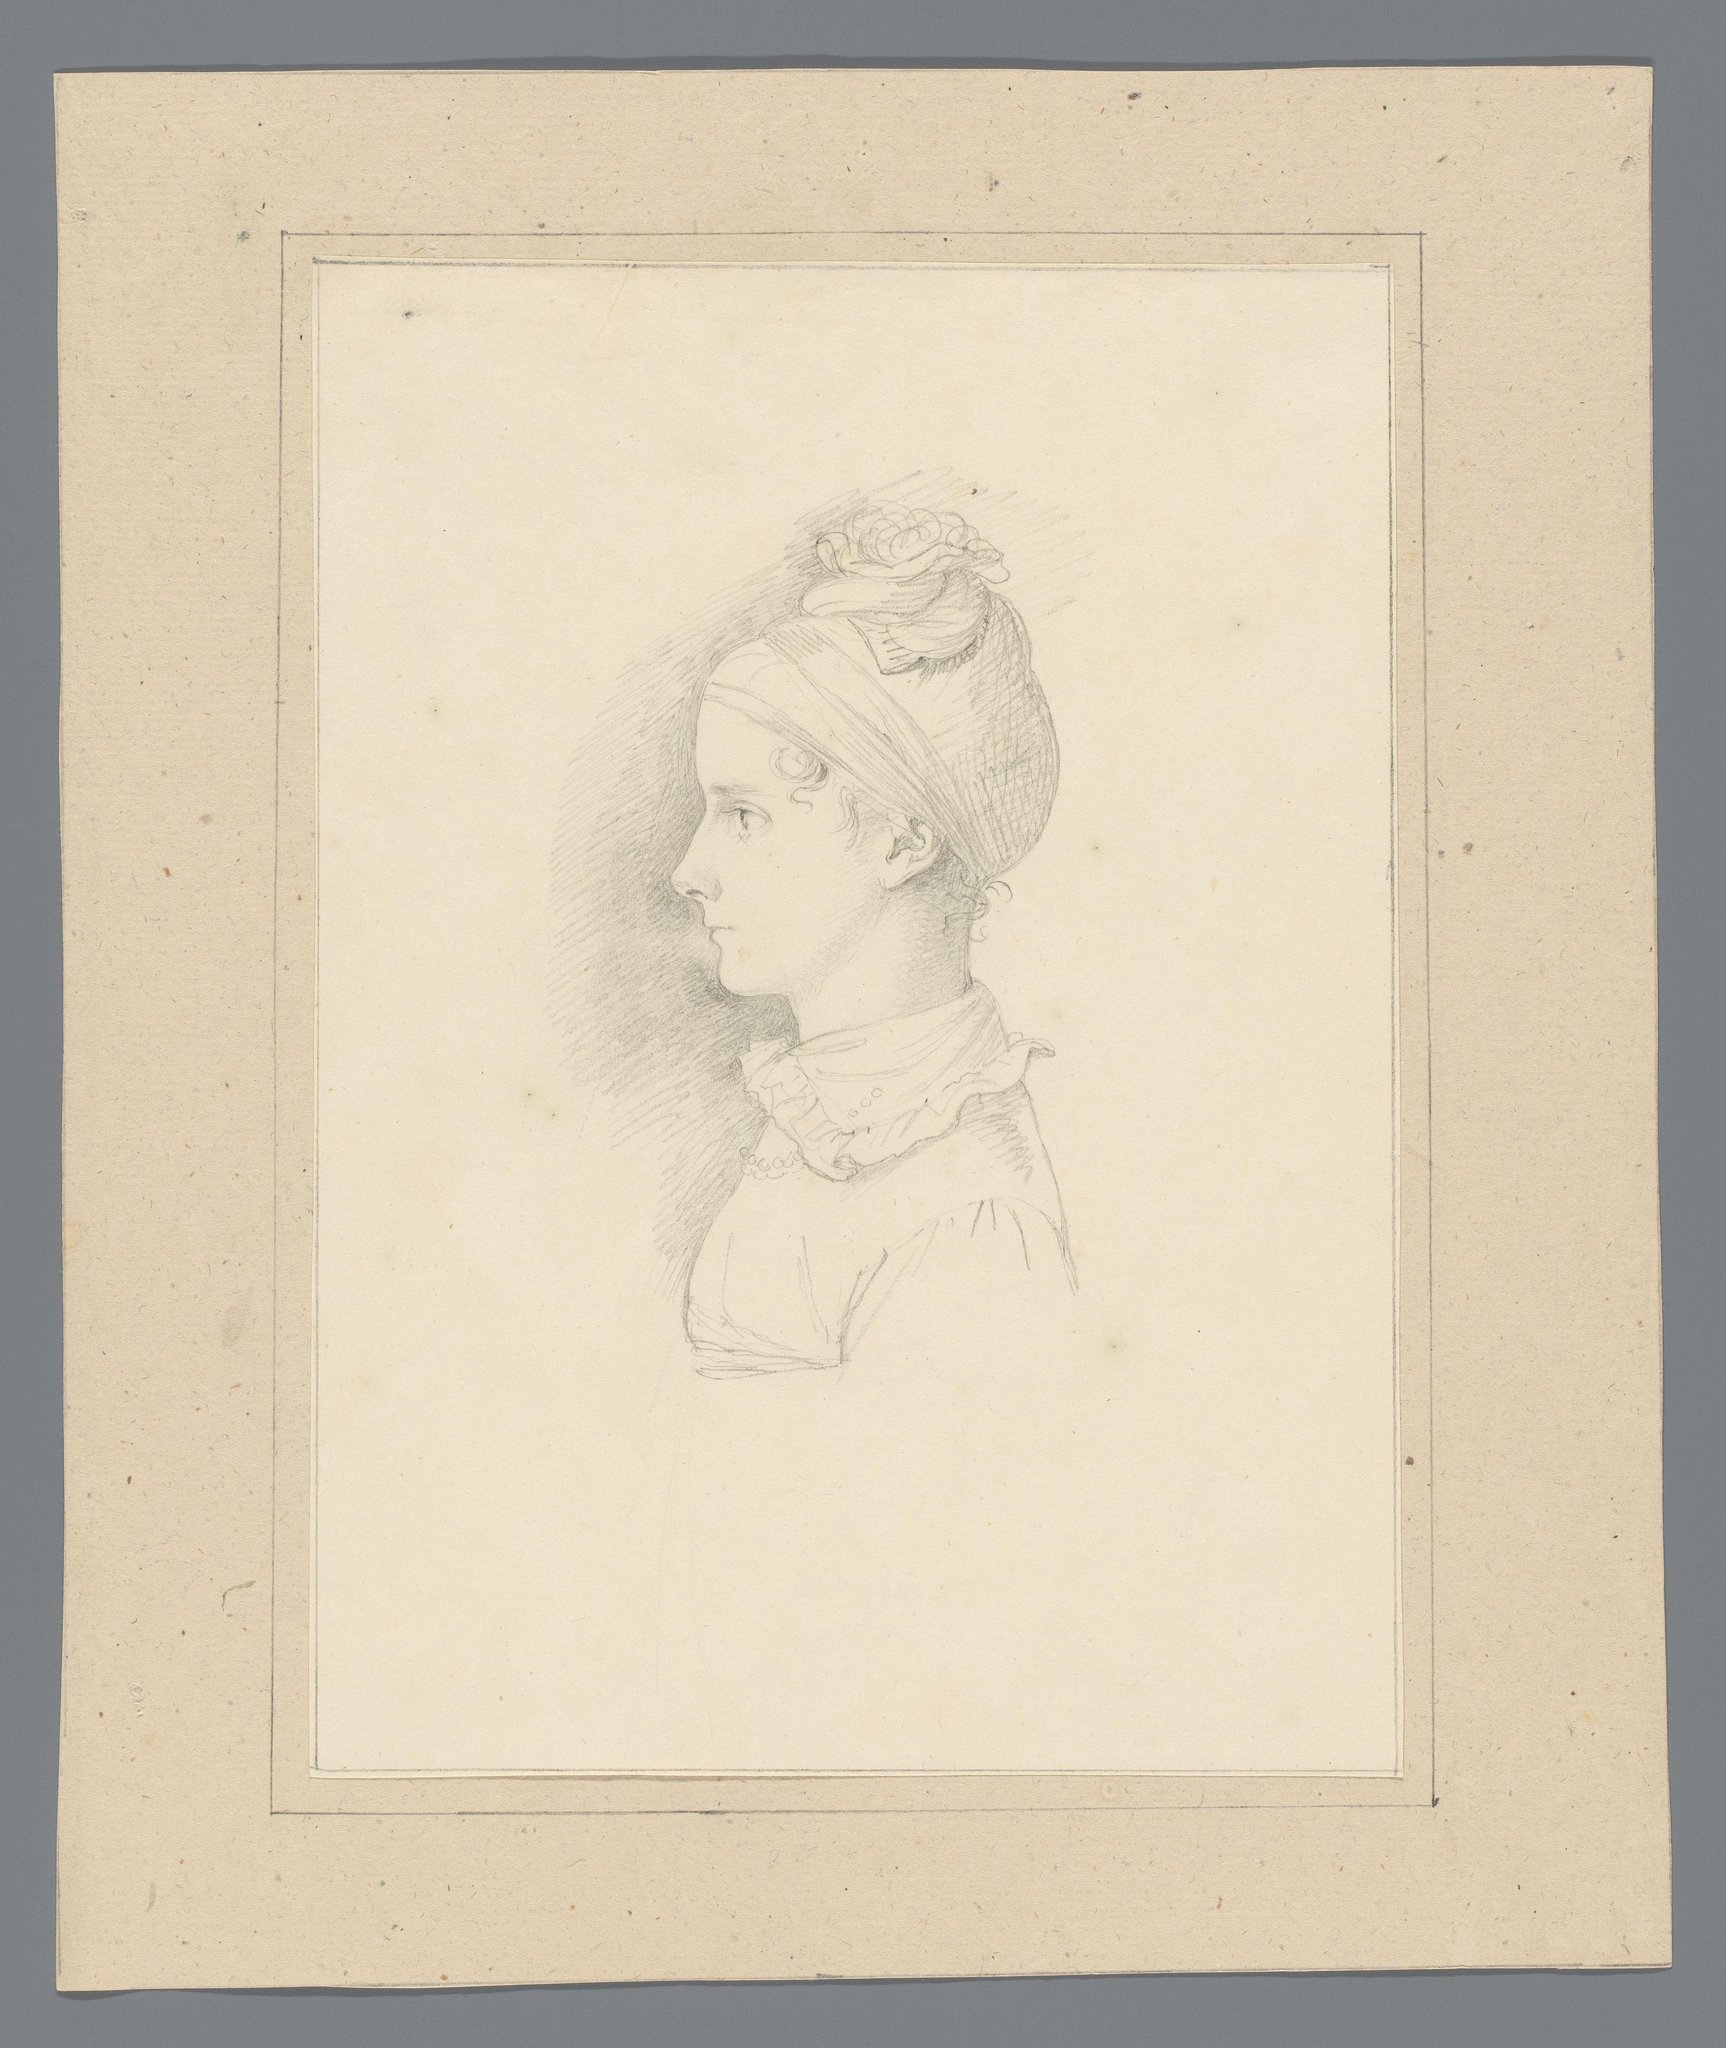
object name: drawing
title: Hoofd van een meisje en profil naar links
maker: david pièrre giottino humbert de superville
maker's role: draughtsman, painter, print maker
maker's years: 1770-1849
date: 1780-1849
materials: paper, pencil